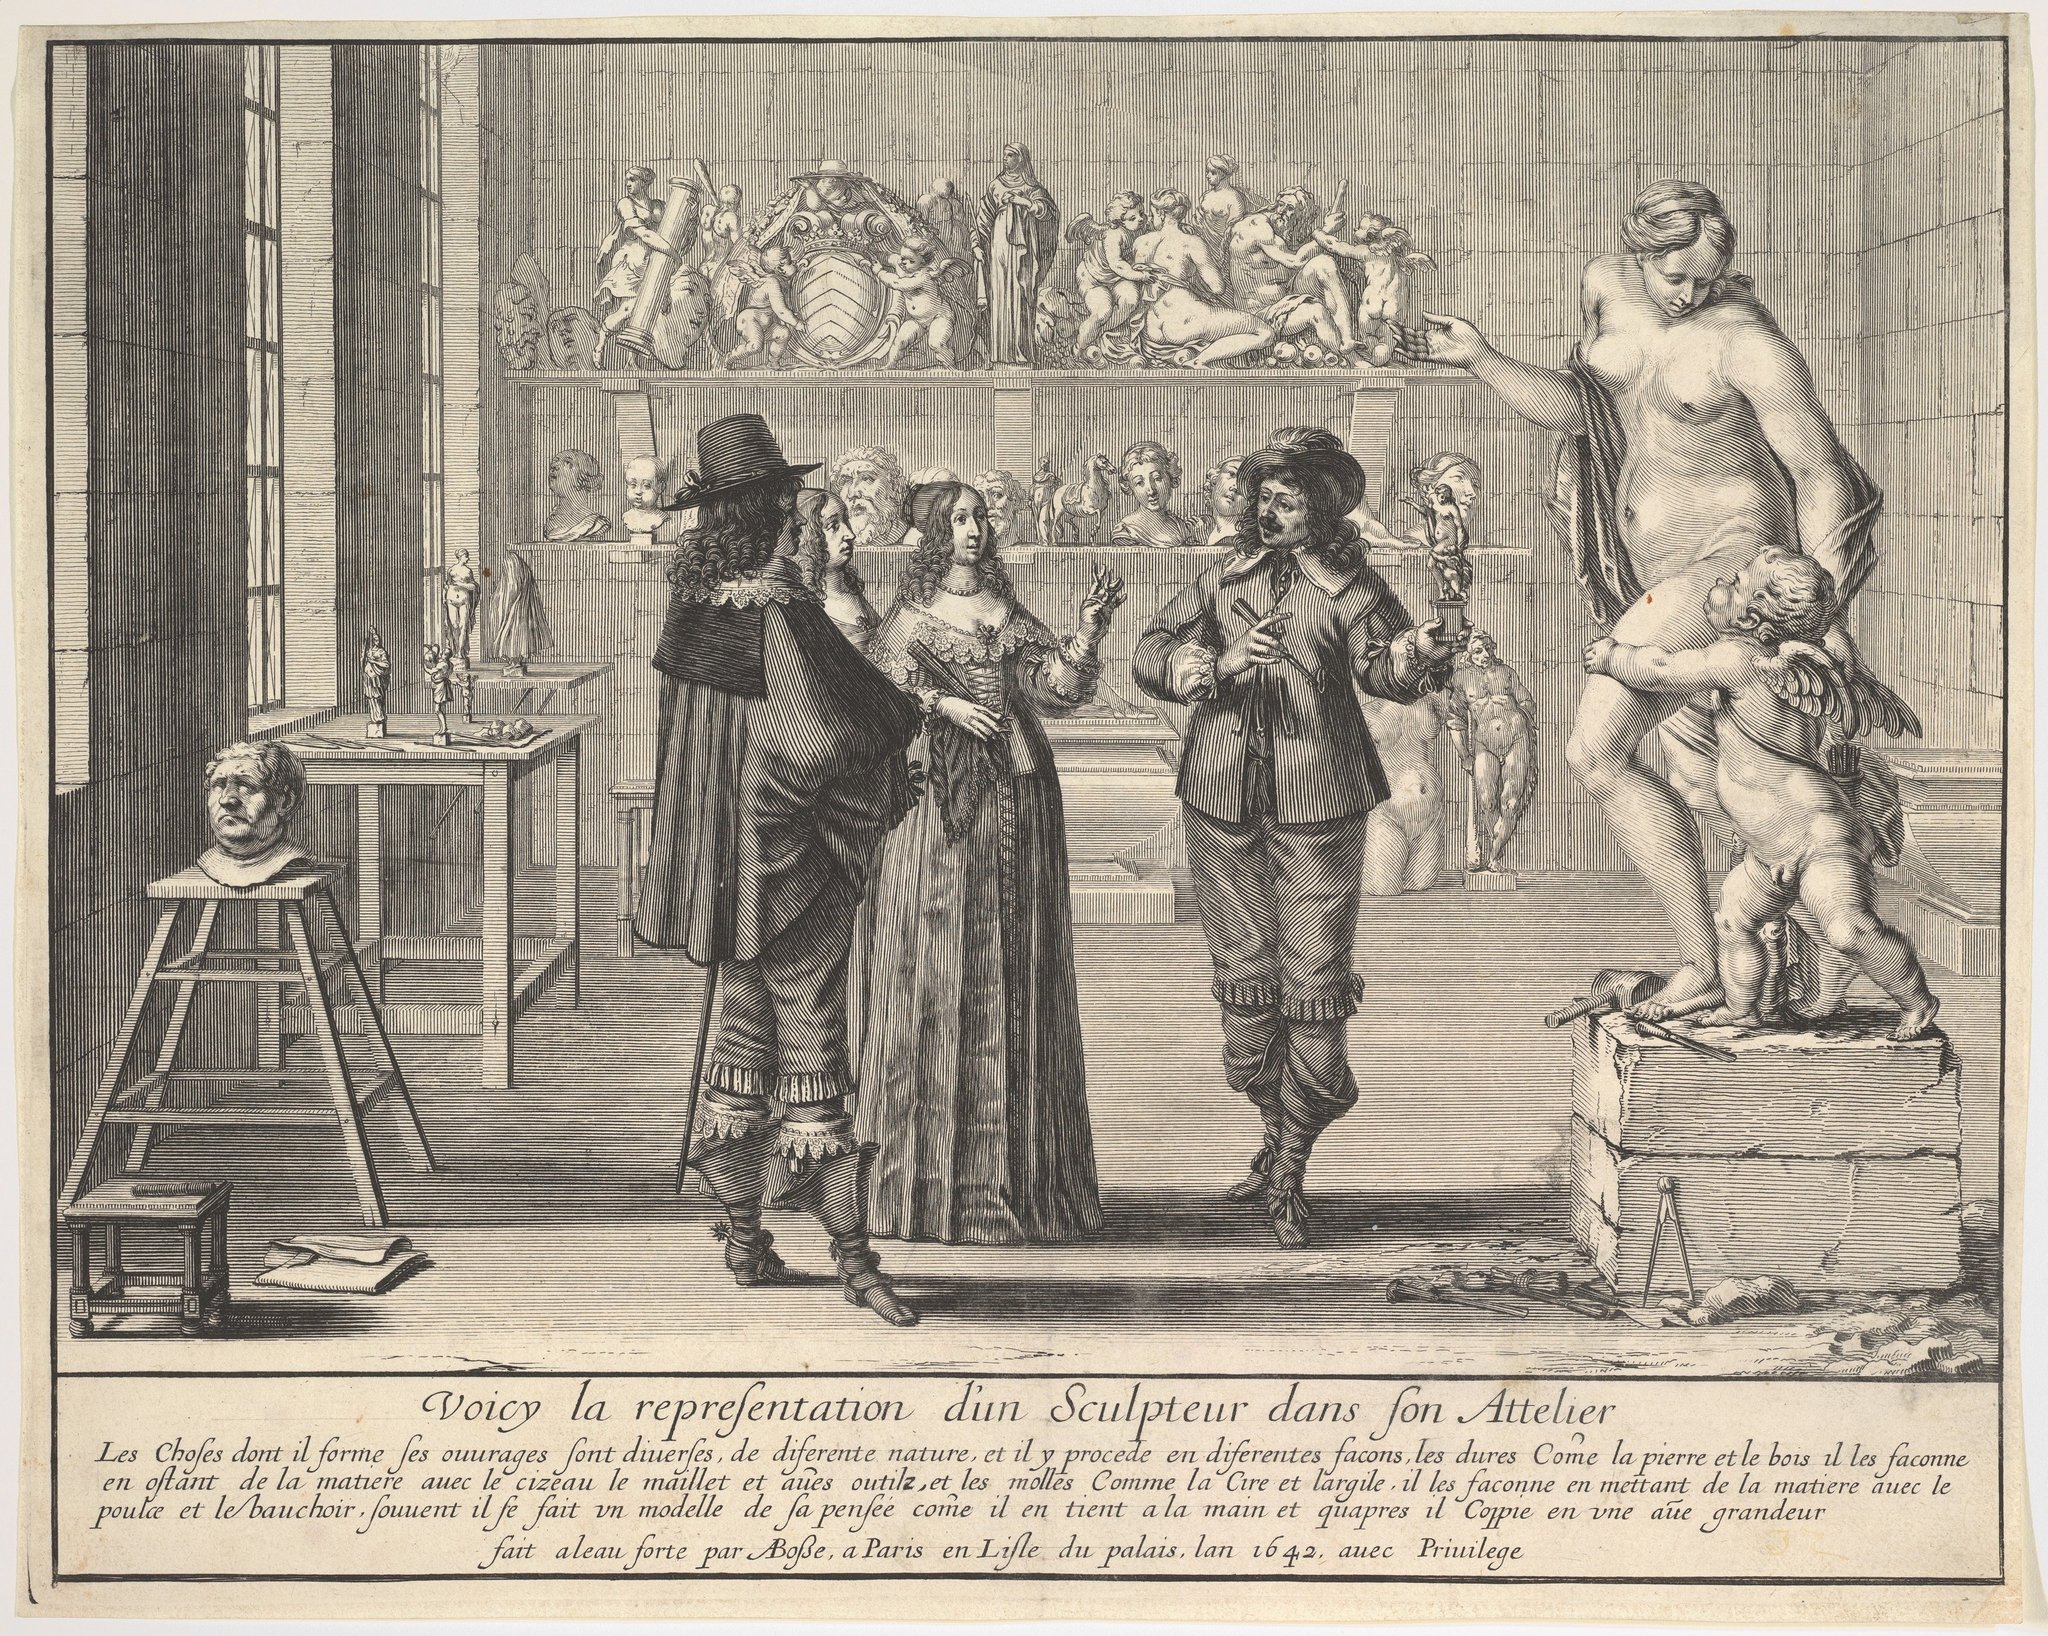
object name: print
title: A Sculptor Presenting his Statue of Venus and Cupid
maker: abraham bosse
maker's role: artist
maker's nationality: french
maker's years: 1602-1676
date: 1642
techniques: etching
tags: men,women,cupid,venus